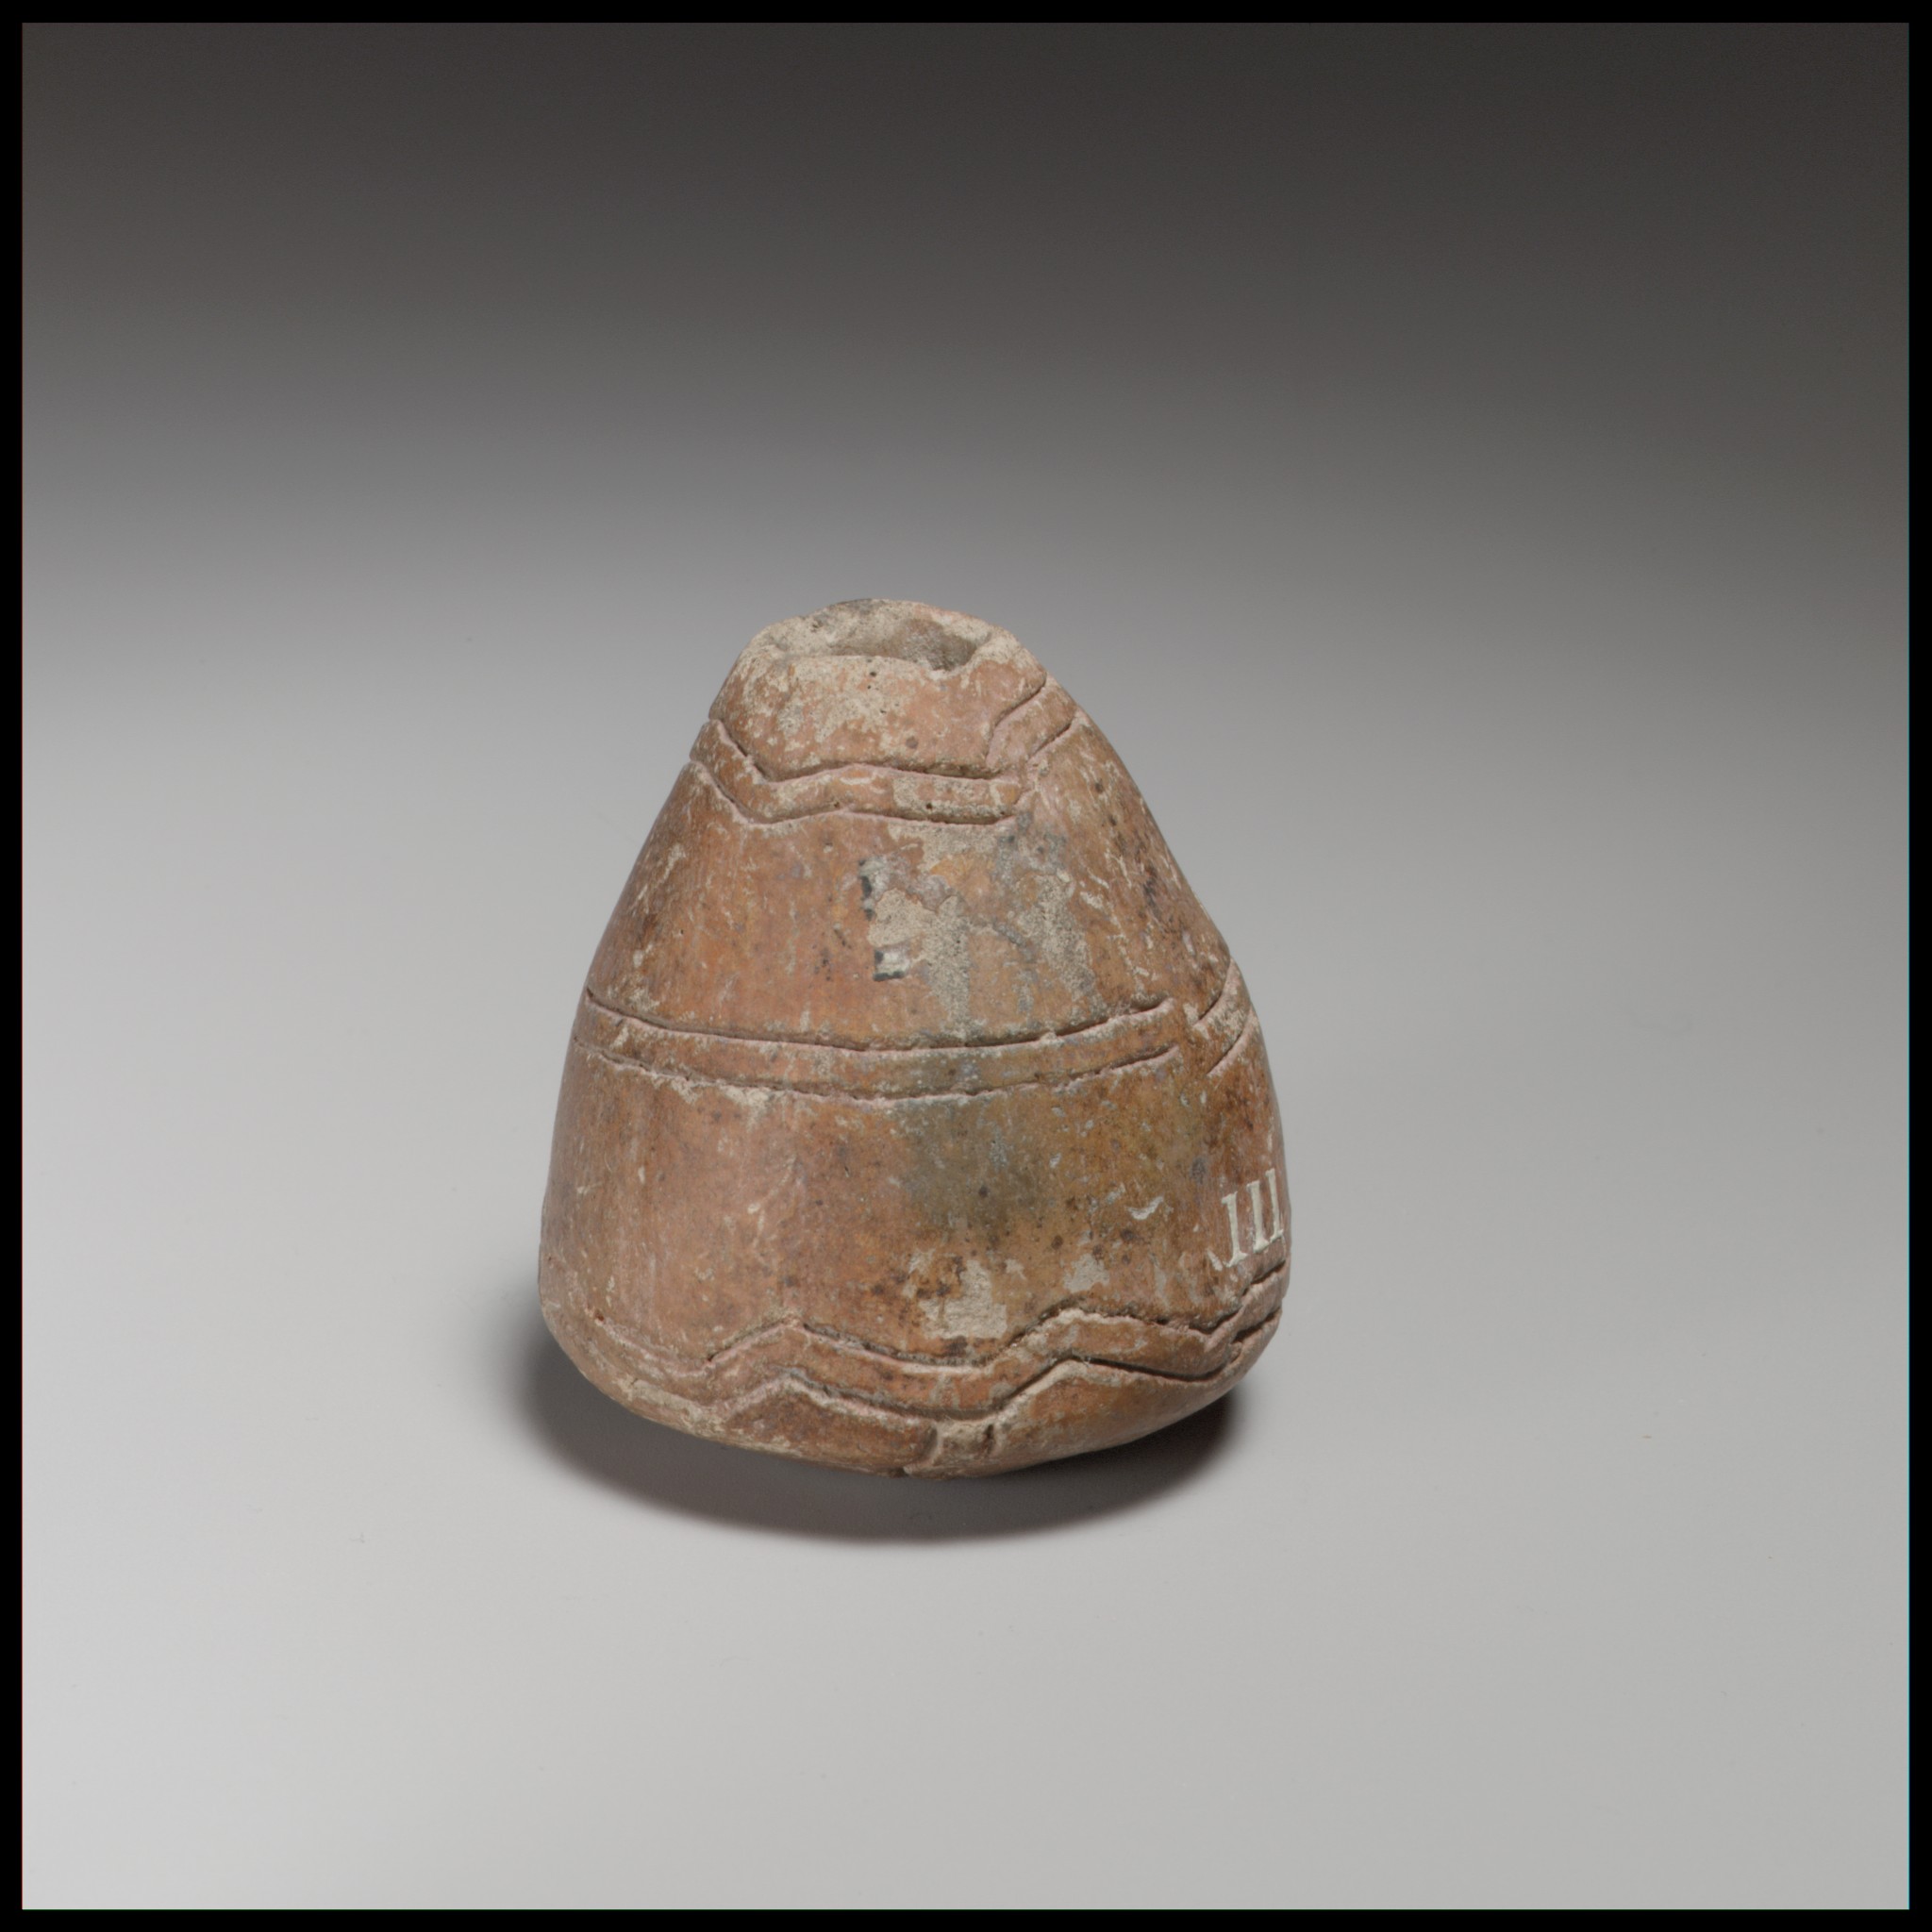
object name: spindle whorl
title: Conical-hemispherical spindle-whorl with slightly rounded base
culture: cypriot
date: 2000-1725 BCE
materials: terracotta